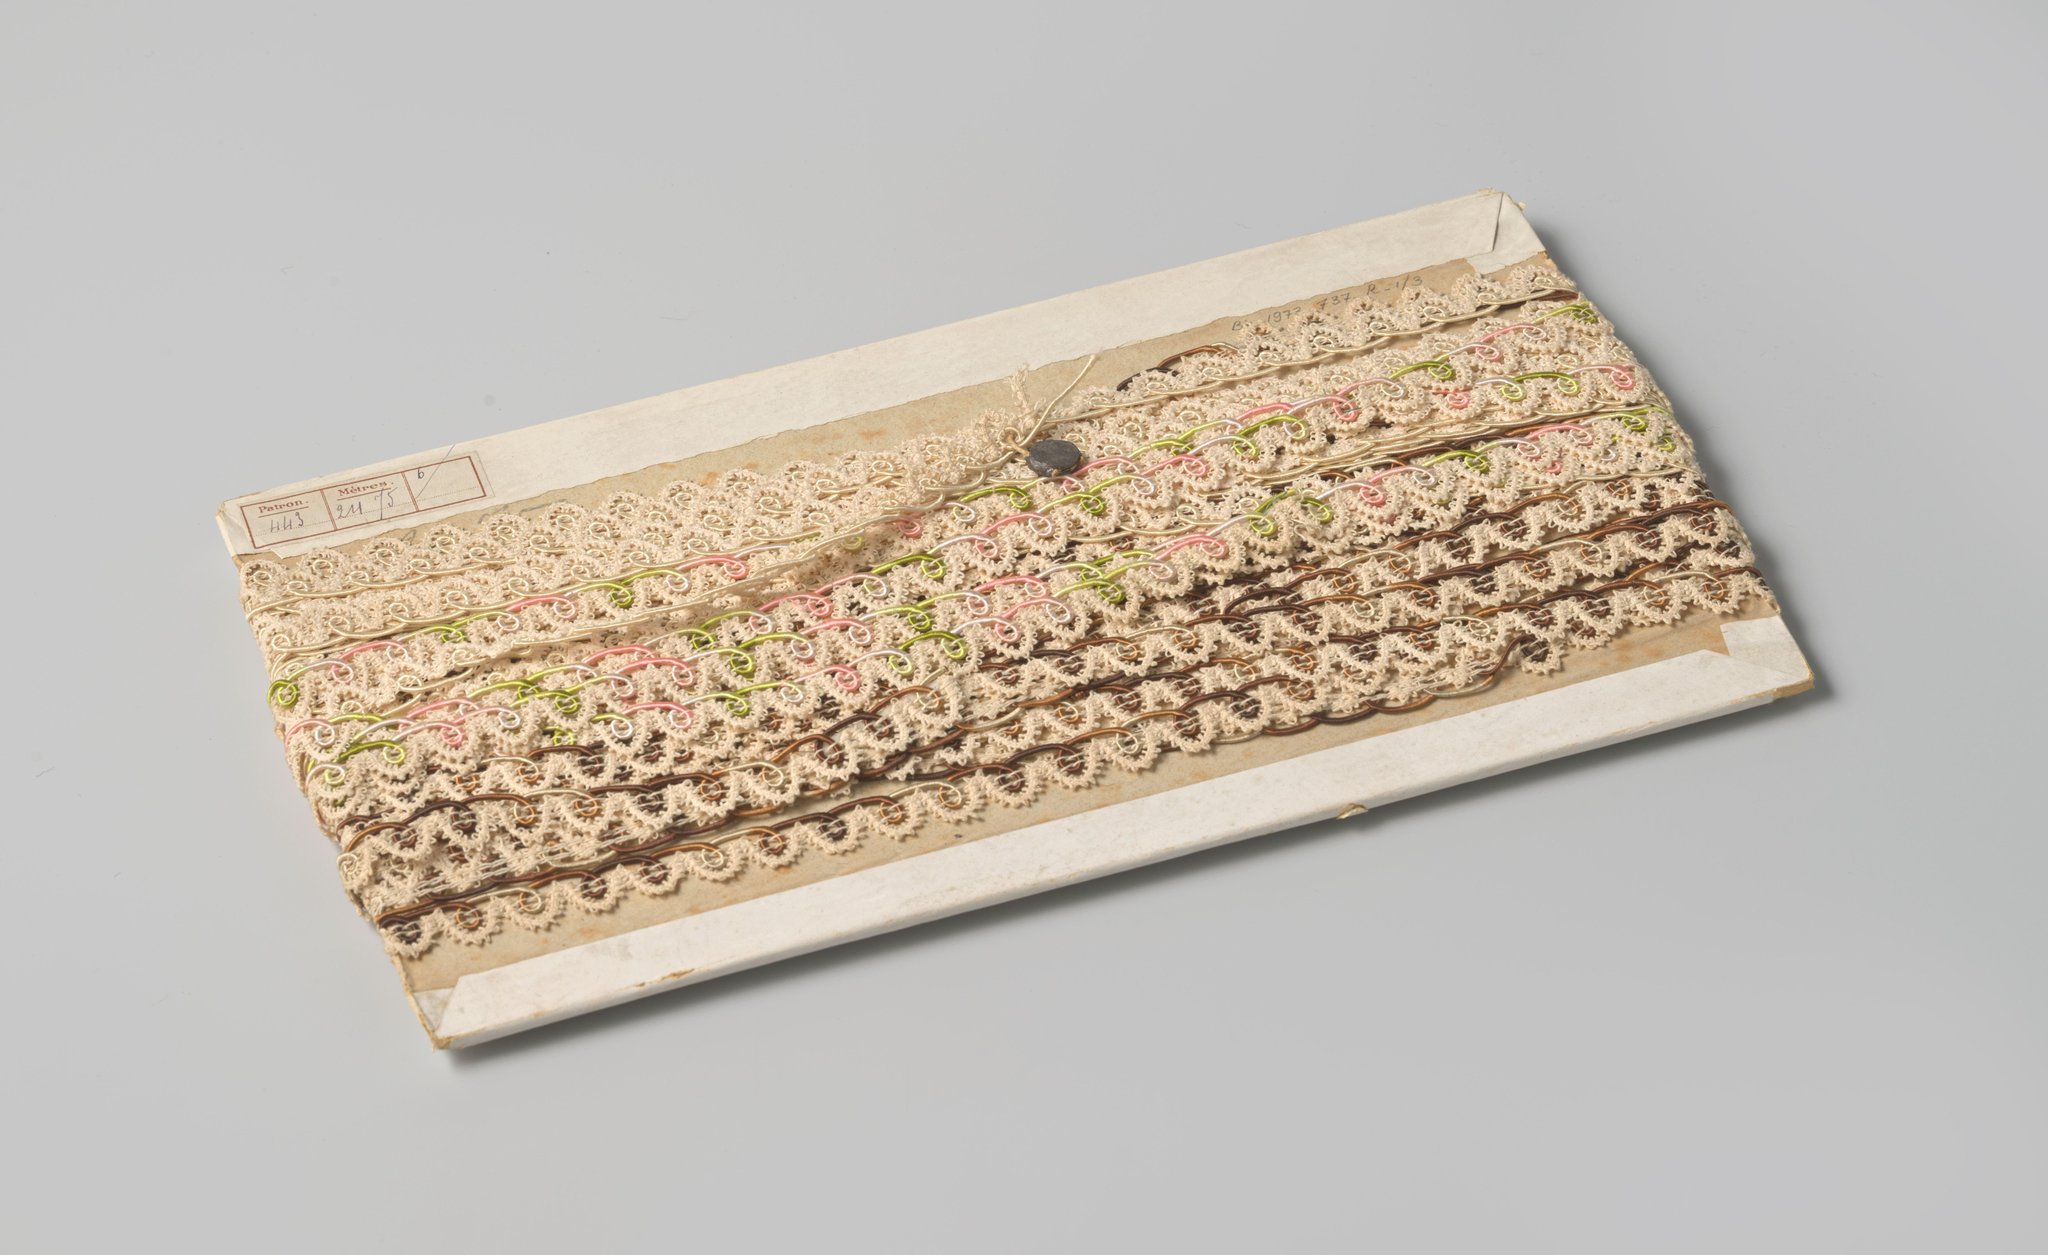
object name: strip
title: Passement van geschulpte witte kant voorzien van picots doorweven met een ondulerende glanzende bruine draad, op karton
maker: gustav schnitzler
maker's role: paraplufabrikant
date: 1925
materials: cardboard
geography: nijmegen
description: Passement van geschulpte witte kant voorzien van picots doorweven met een ondulerende glanzende bruine draad, op karton.